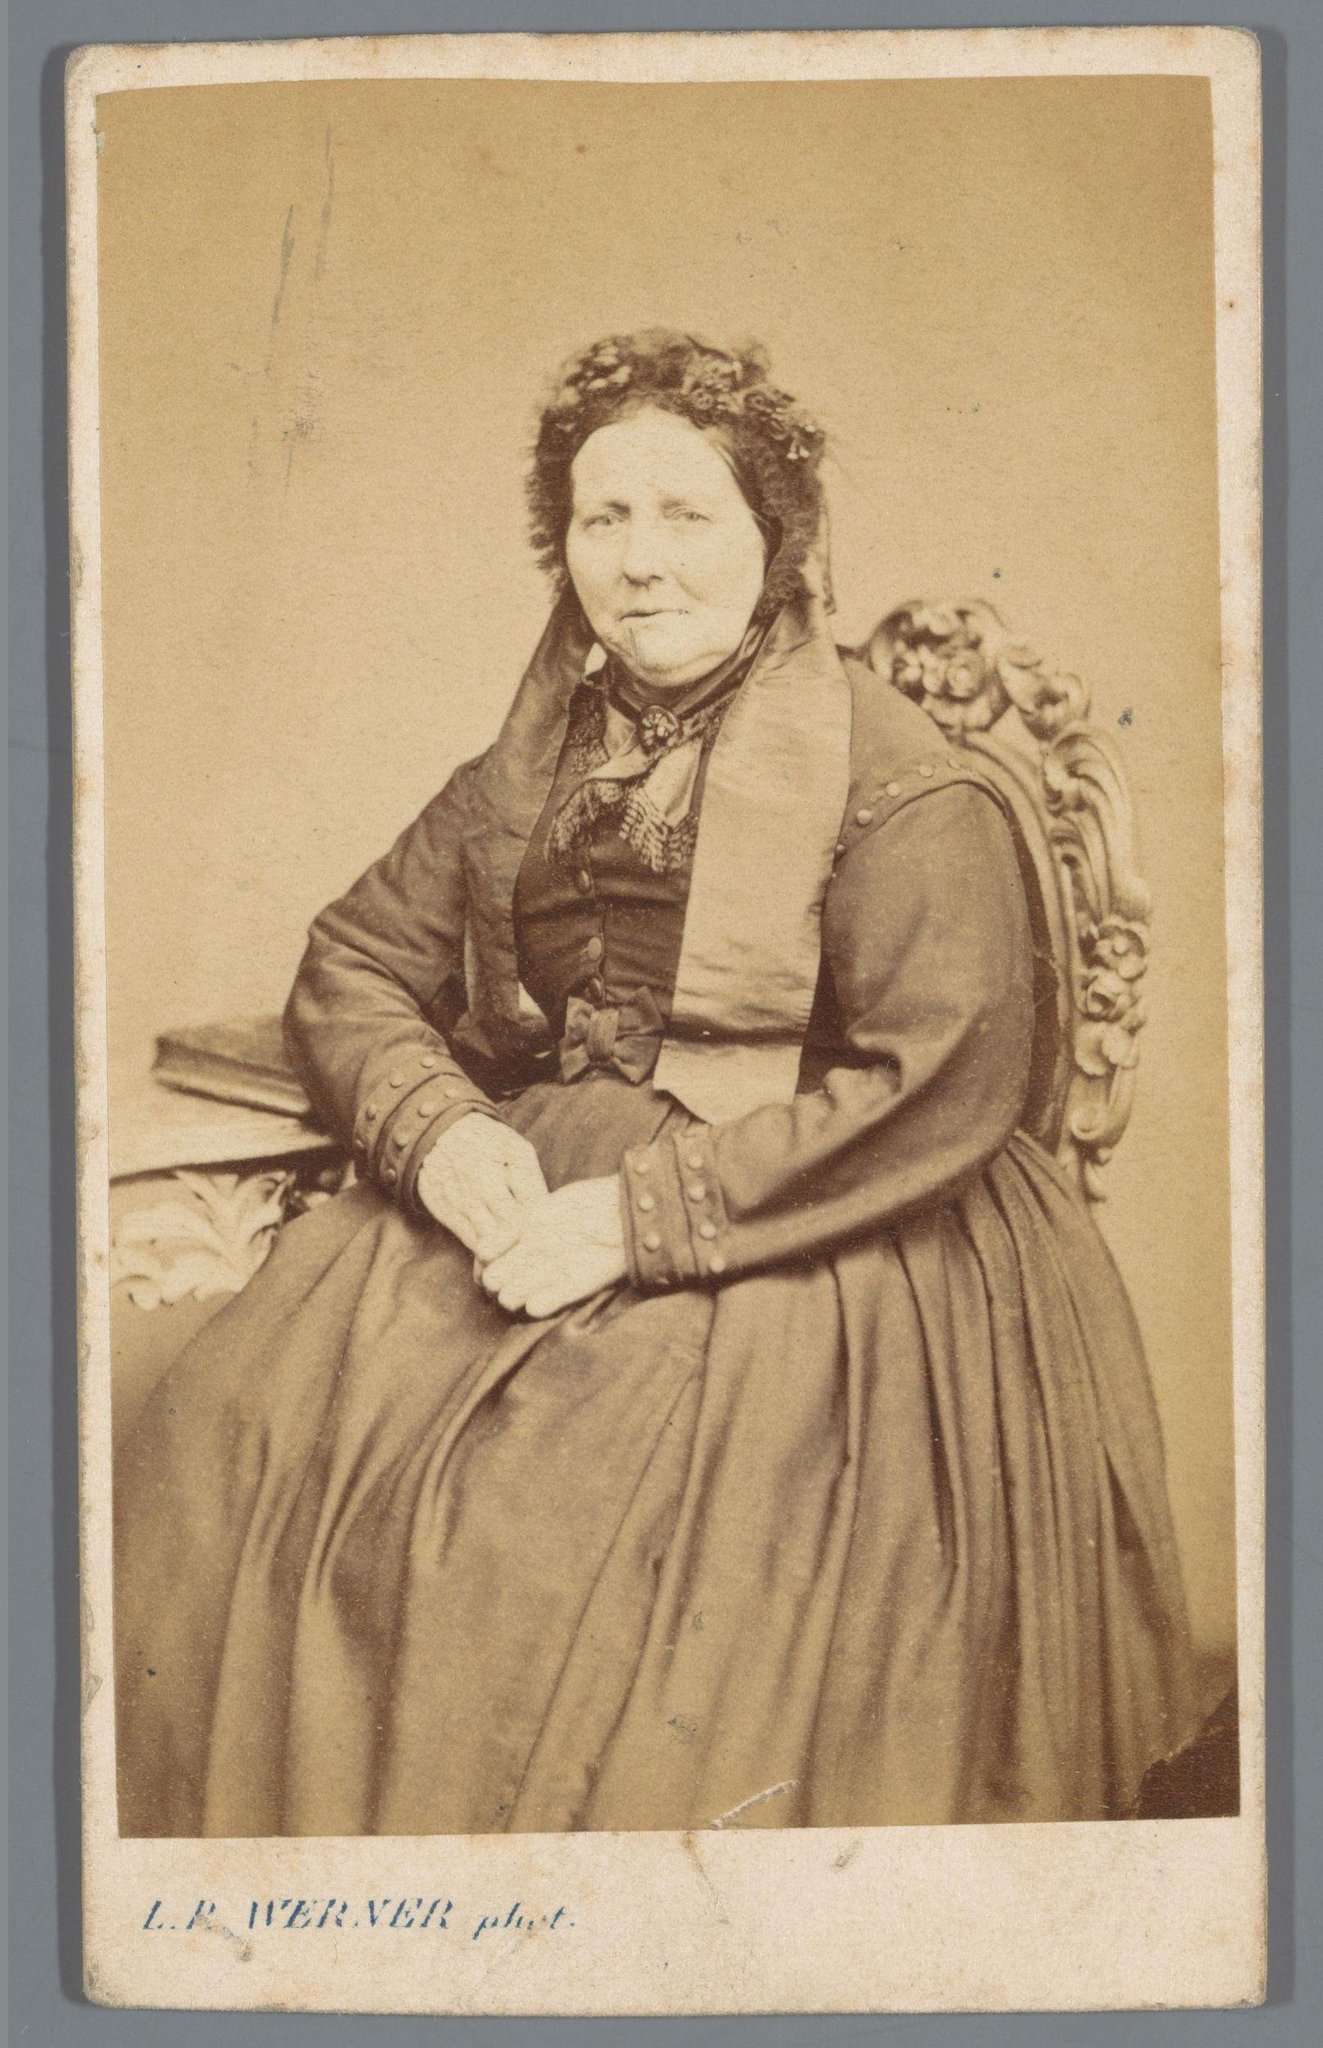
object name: photograph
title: Portret van een onbekende zittende vrouw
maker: louis robert werner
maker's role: fotograaf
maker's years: 1834-1896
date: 1871-1877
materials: cardboard, paper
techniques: albumen print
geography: amsterdam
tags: adult woman, anonymous historical person portrayed, amsterdam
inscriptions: inscription: ‘Photographisch Atelier/ van/ L.R. Werner/ voorheen/ P. Carstensen/ Nieuwendijk H 201/ Amsterdam.’, inscription: ‘L.R. Werner phot.’